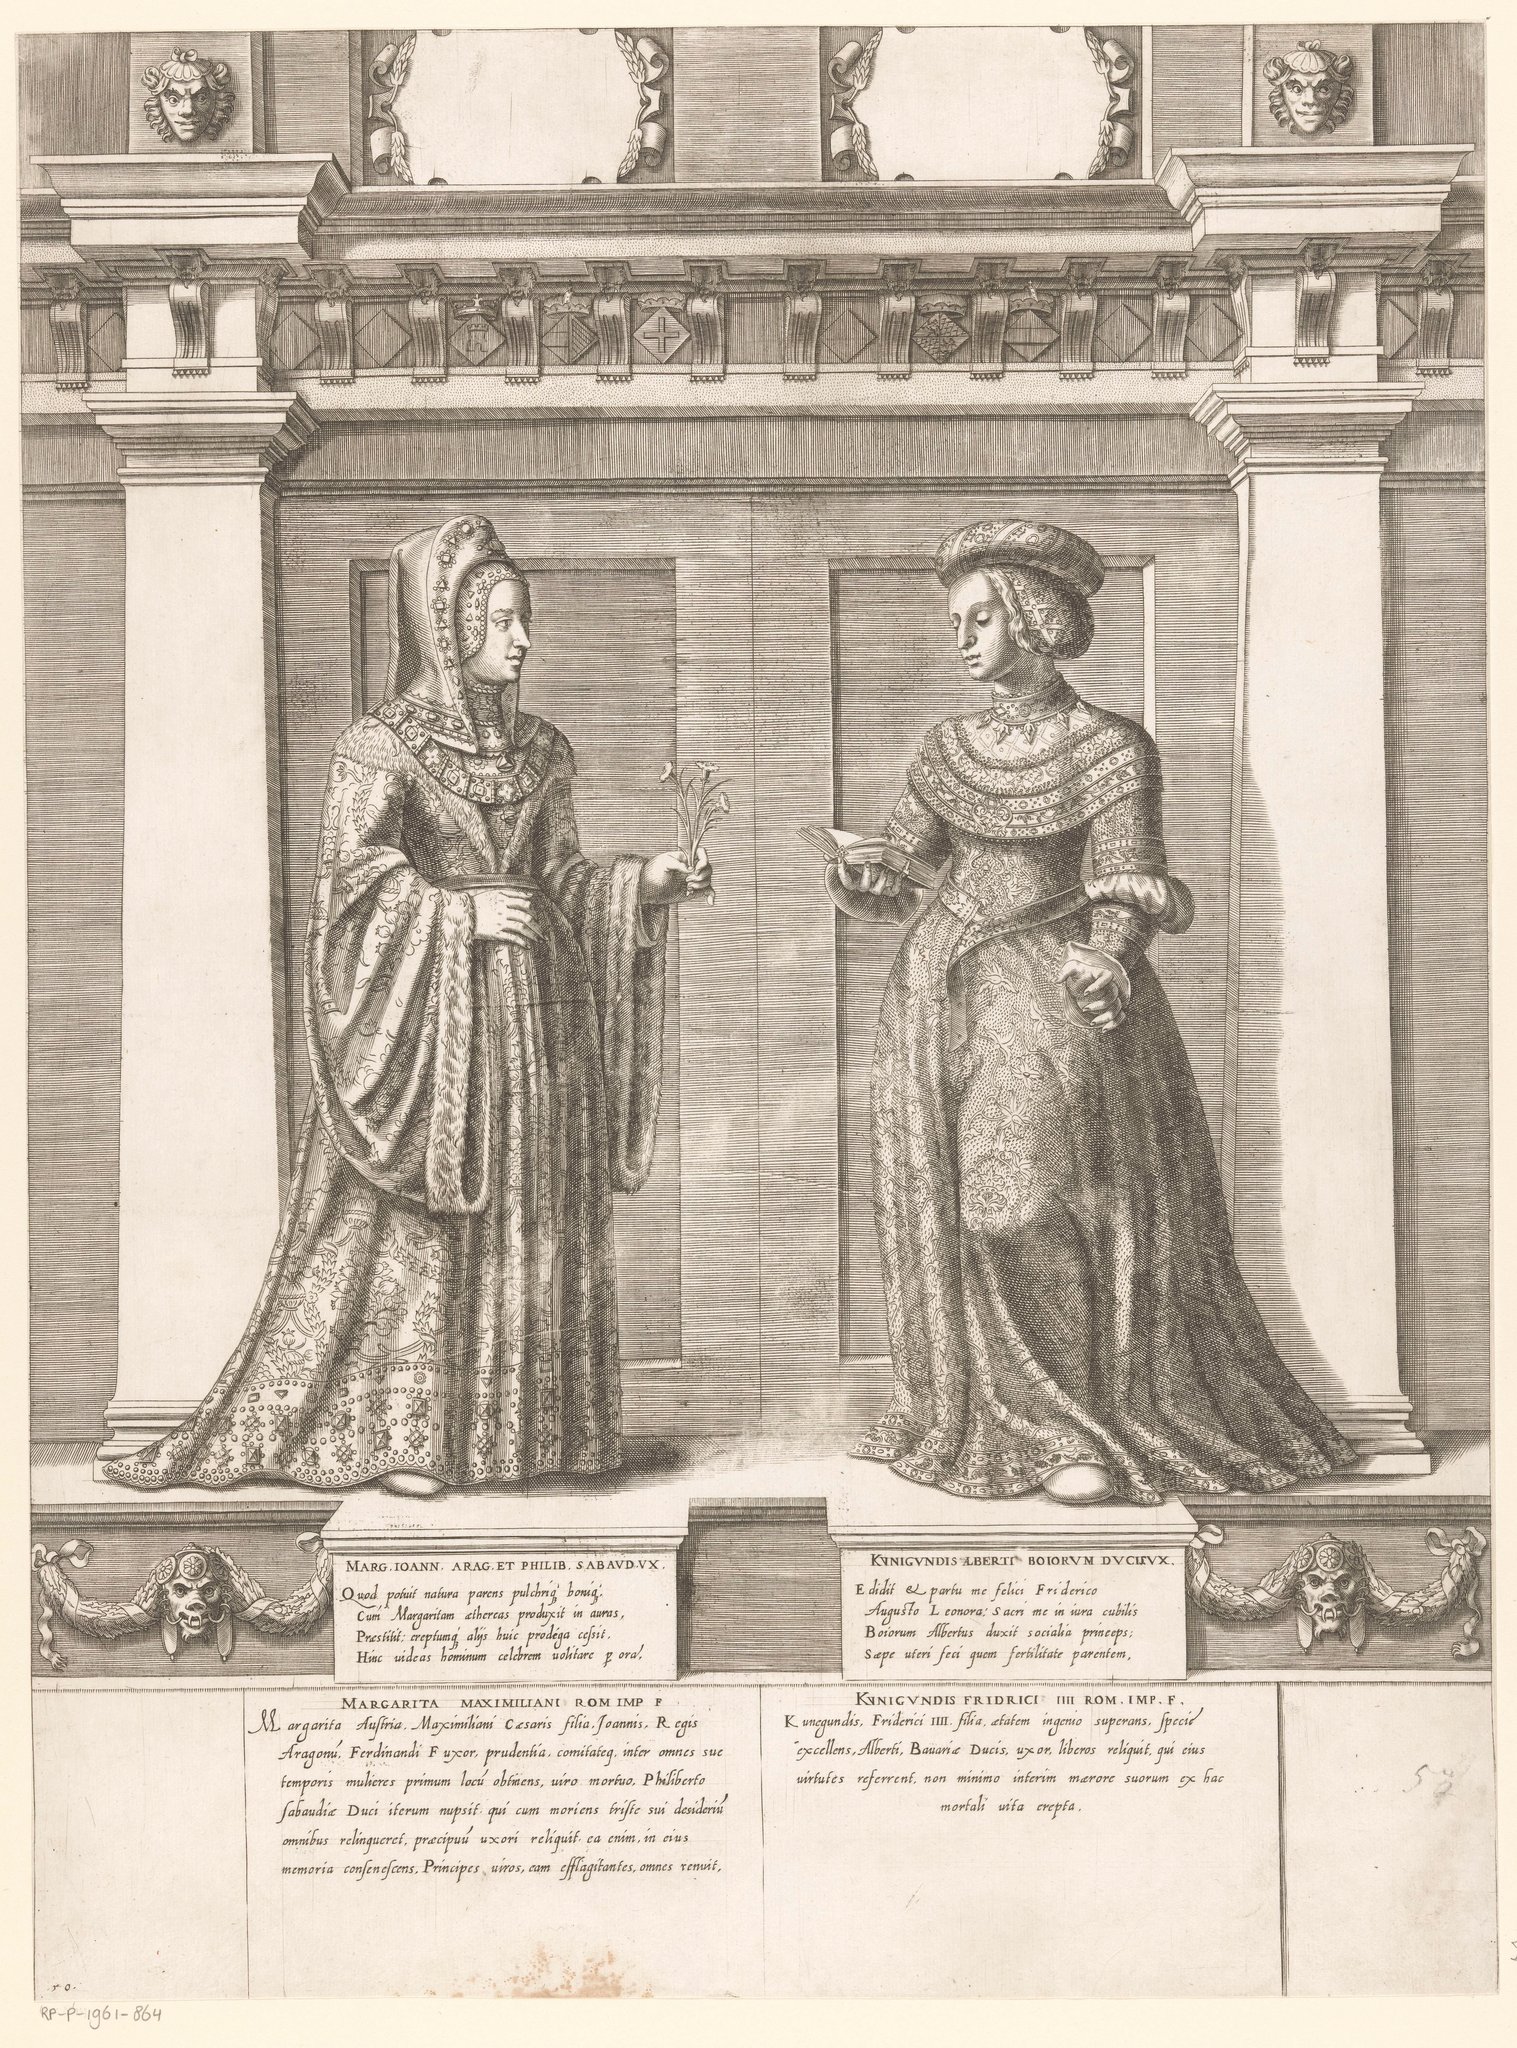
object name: print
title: Austriacae gentis imaginum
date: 1569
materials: paper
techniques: engraving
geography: italy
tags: brussels, mechelen, historical persons - bb - woman, ruler, sovereign - bb - female ruler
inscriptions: collector's mark: Lugt 2228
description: Deze prent maakt deel uit van een reeks van 58 prenten. Het meerendeel van de prenten bevat portretten van 74 leden van het Oostenrijkse Huis, naar tekeningen door Francesco Terzio, die deels getekend zijn naar de 28 levensgrote bronzen beelden die rond de cenotaaf van Maximiliaan I in de Hofkirche te Innsbruck staan. Op het object staat nummer 50, maar in de literatuur wordt de prent genoemd als prent 51 uit de reeks.